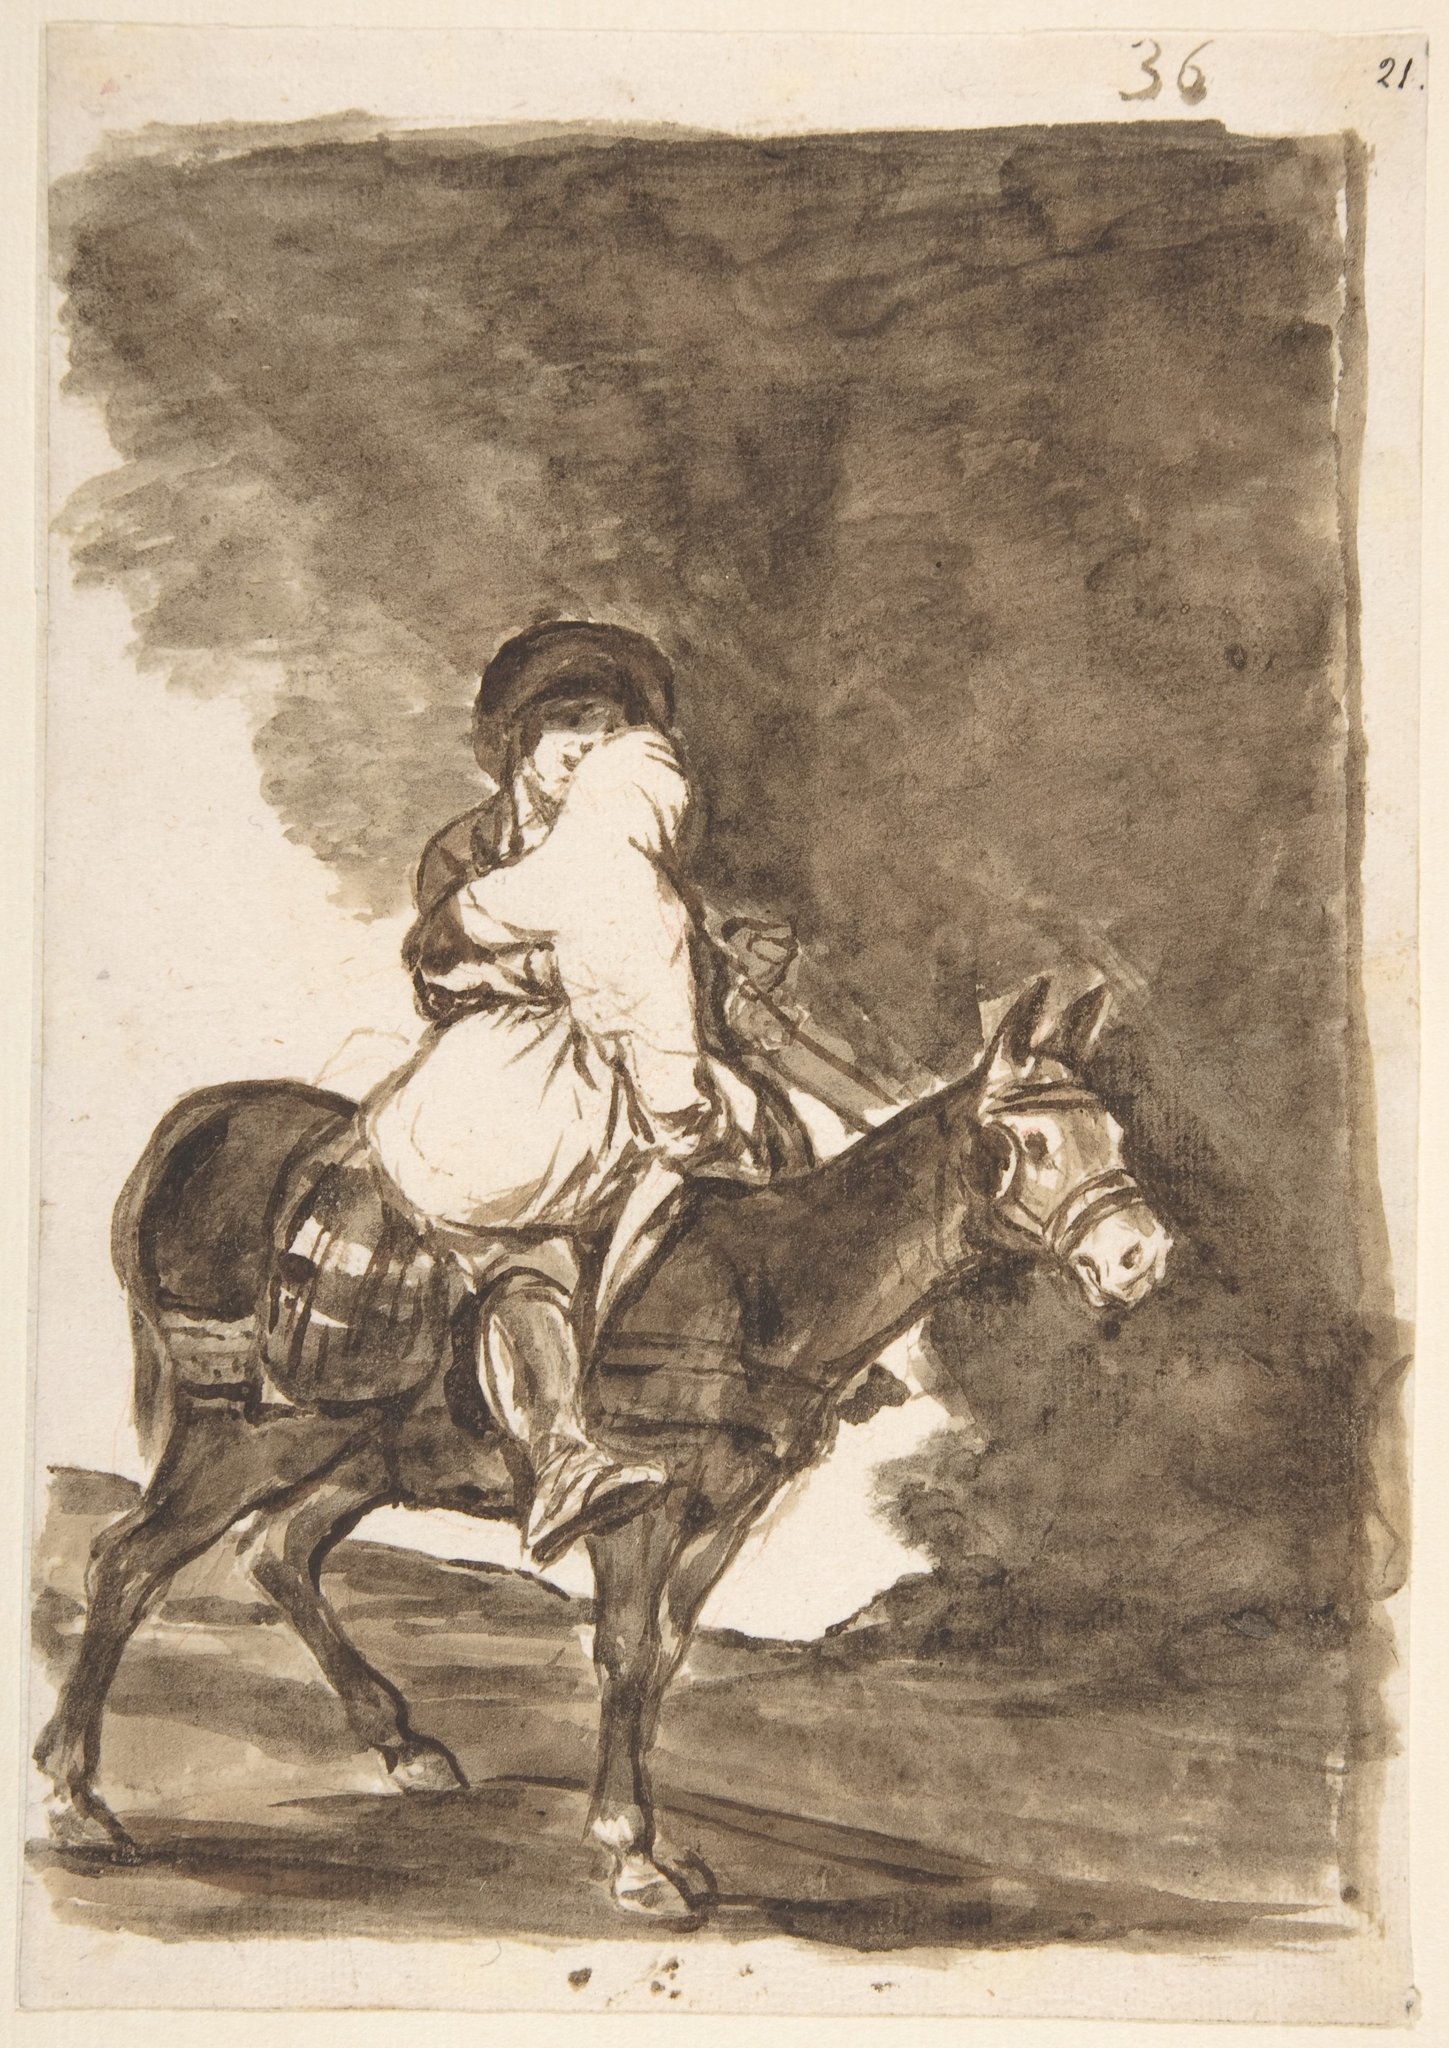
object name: drawing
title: A man and a woman riding a mule; page 36 from the "Images of Spain" Album (F)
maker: goya (francisco de goya y lucientes)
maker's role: artist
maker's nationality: spanish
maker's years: 1746-1828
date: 1812-1820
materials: chalk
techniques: brush, wash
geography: spain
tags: animals,men,women